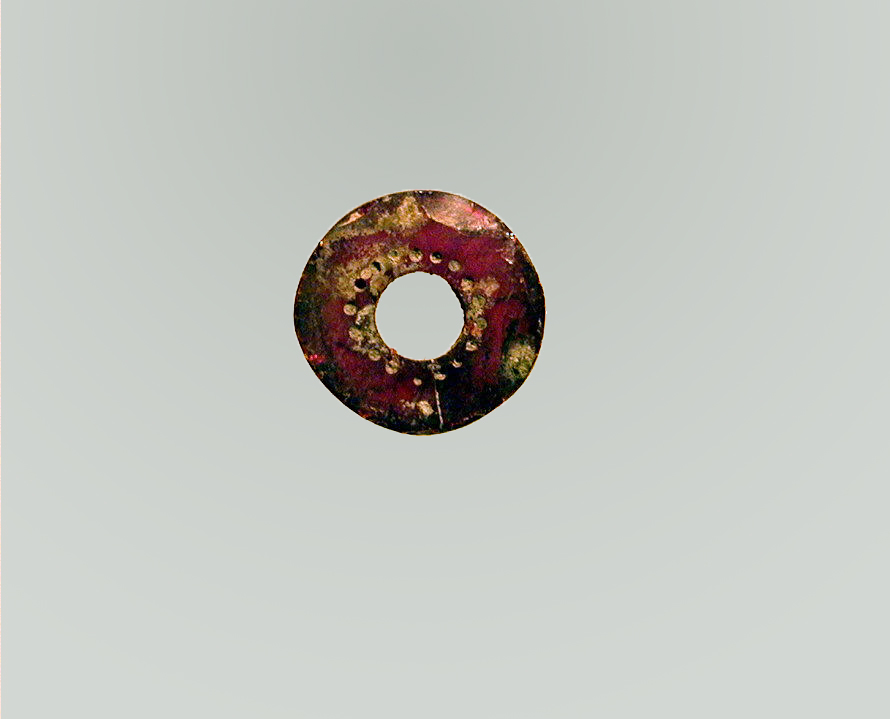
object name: fibula, fragment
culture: etruscan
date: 700-501 BCE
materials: amber